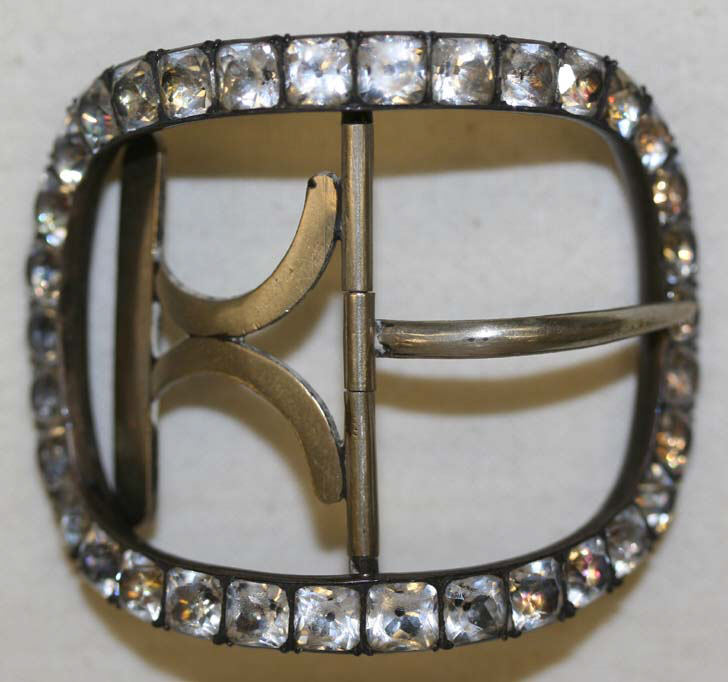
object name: shoe buckle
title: Shoe buckles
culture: british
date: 1767-1800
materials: metal, paste